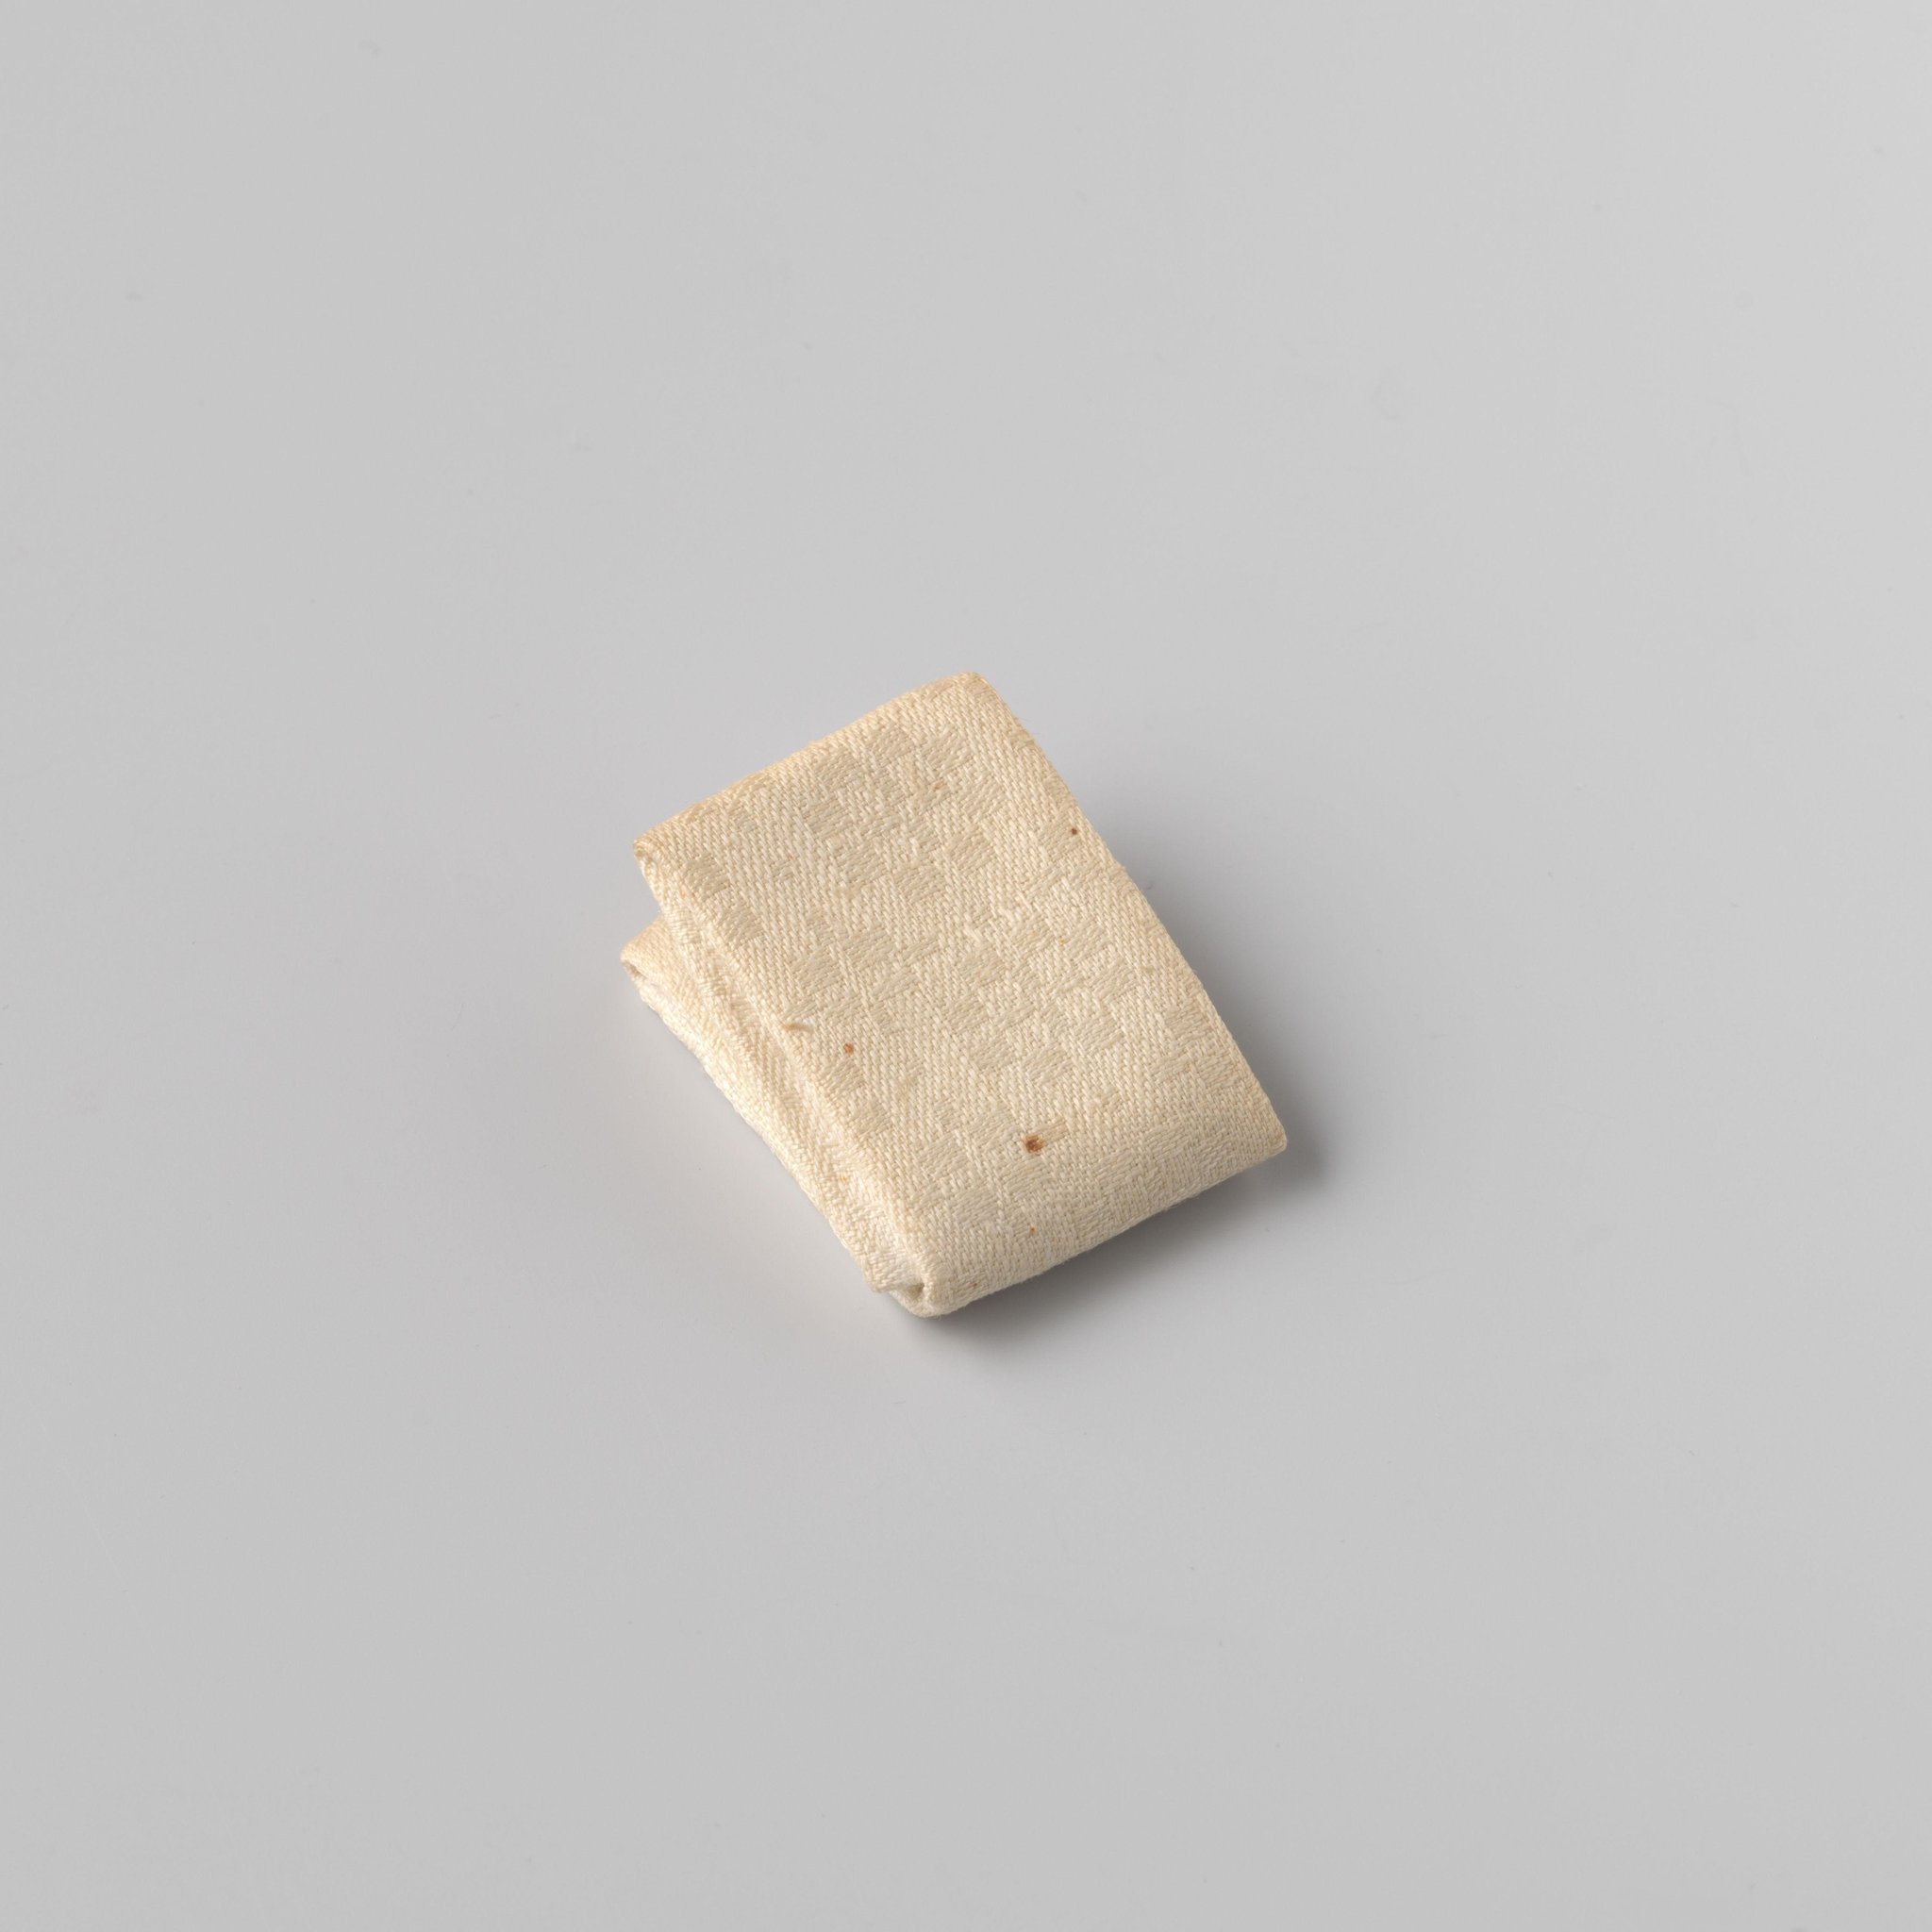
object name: miniature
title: Linnen servet van damastweefsel met pellenpatroon (motief II), aan vier zijden omzoomd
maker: Anonymous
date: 1690-1710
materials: linen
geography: amsterdam